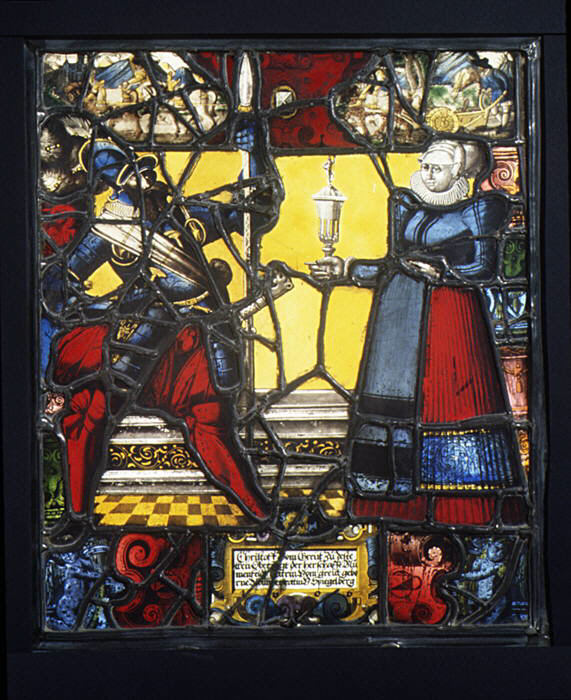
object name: welcome panel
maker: anonymous, swiss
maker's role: artist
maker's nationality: swiss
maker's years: 1400-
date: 1601-1633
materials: glass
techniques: enamel, stain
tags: armor,spears,men,women